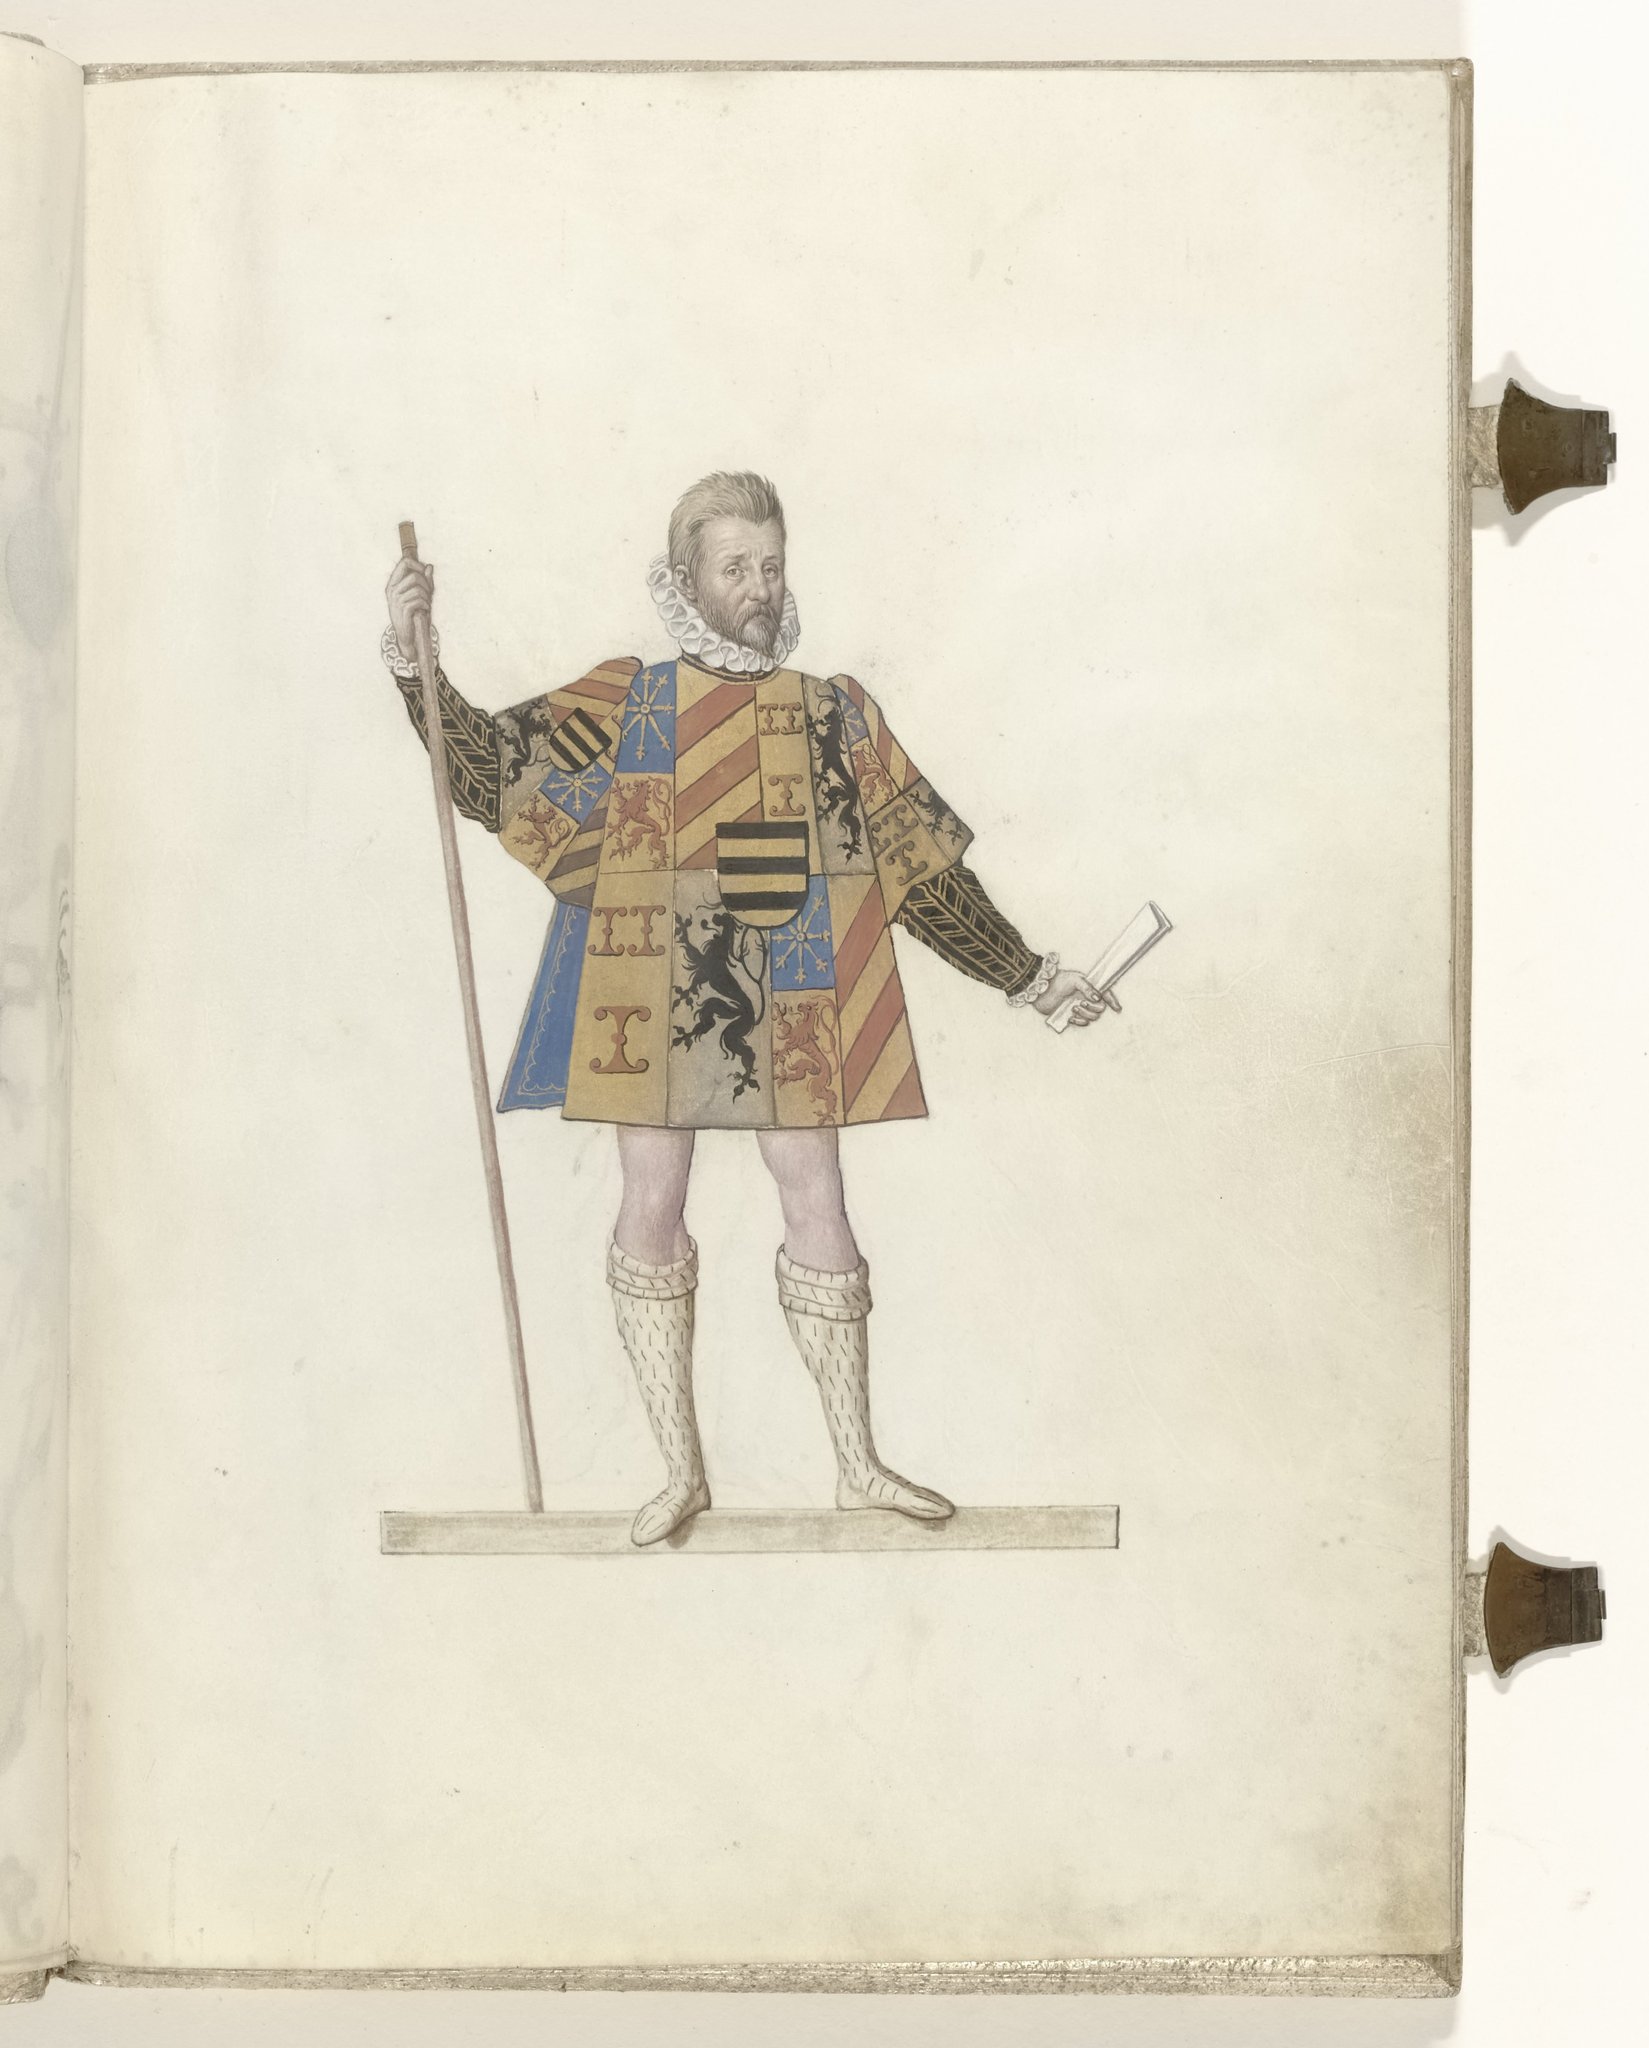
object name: drawing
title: Herald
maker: nicolaes de kemp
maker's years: 1550-1633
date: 1590-1593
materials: paint, gouache, ink, parchment, watercolor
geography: northern netherlands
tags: herald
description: Heraut in wapenrok met de wapens van Culemborg, Teisterbant, Walgeris / Aquitanië, Beusichem, Leck en Pallandt. Onderdeel van geïllustreerd handschrift met de genealogie van de heren en graven van Culemborg.